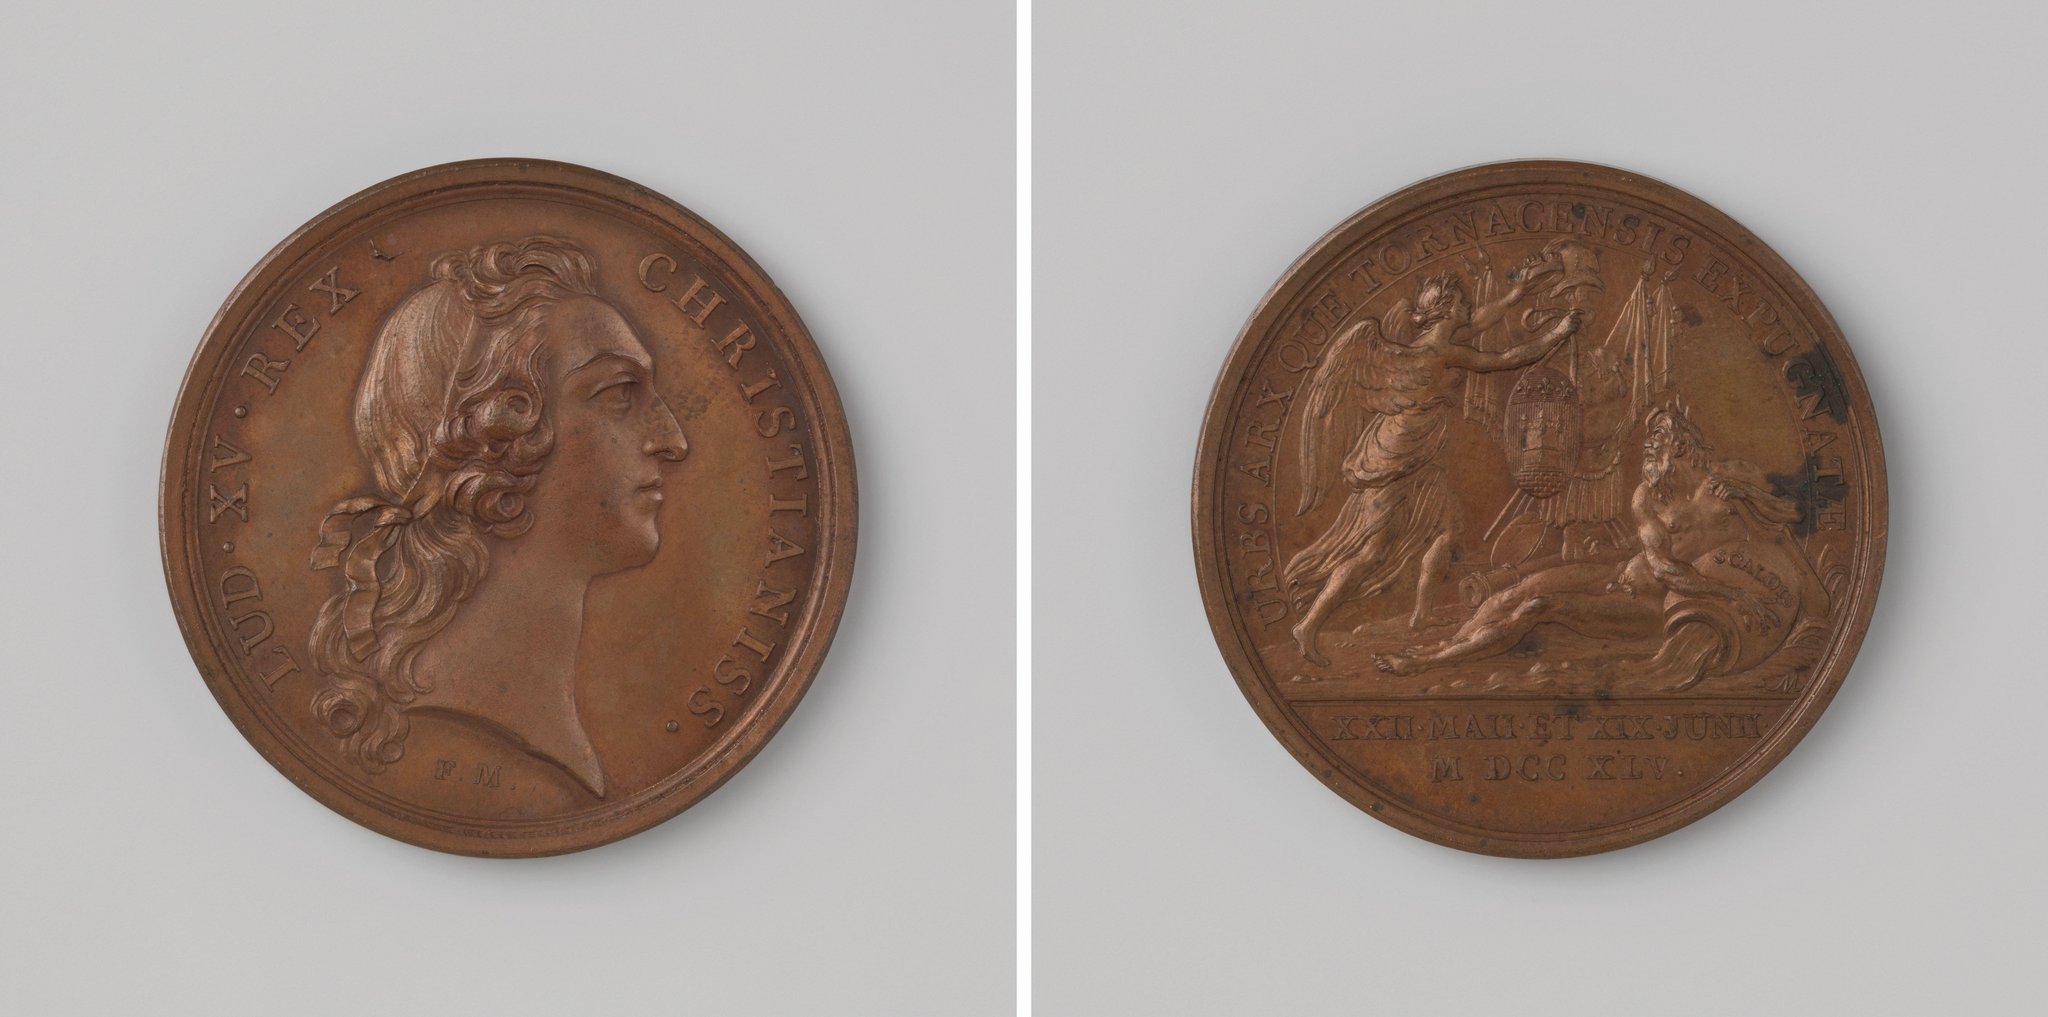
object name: history medal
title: Veldtocht van Lodewijk XV in Vlaanderen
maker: francois joseph marteau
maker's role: medailleur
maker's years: -1757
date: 1745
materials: bronze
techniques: striking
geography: paris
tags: louis xv of france, henegouwen